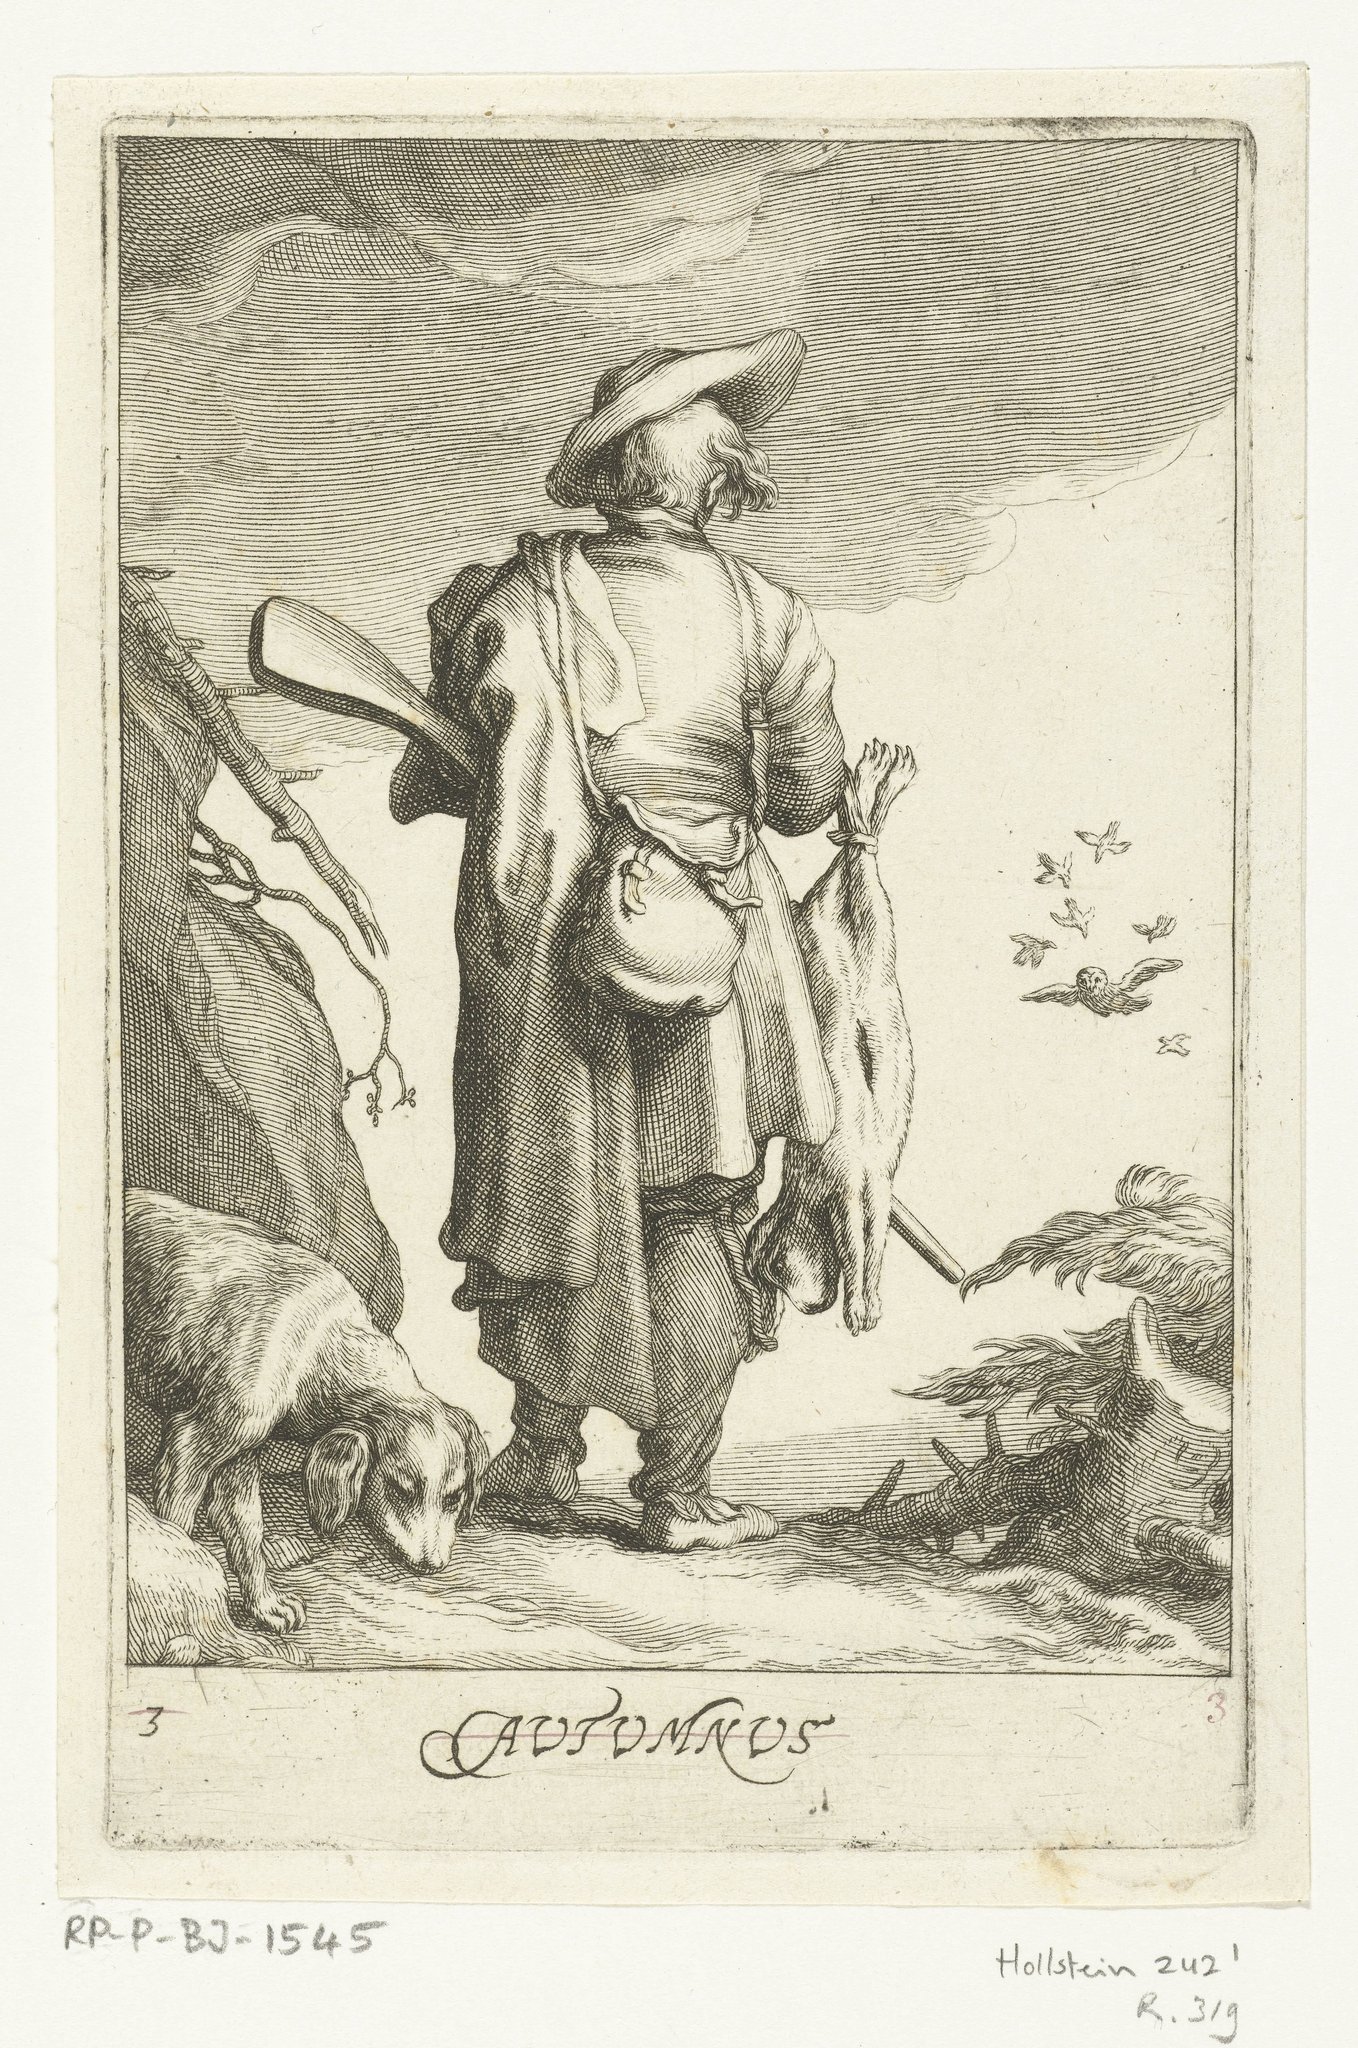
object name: print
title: De vier seizoenen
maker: frederick bloemaert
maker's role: print maker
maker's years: 1614-1669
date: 1632-1670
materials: paper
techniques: engraving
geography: utrecht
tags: autumn, fall, 'autumnus'; 'autunno' (ripa), return from the hunt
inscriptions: number: ‘3’, number: ‘3’, collector's mark: Lugt 240, inscription: ‘Autumnus’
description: Een jager, op de rug gezien, met een geweer, buideltas en een geschoten stuk wild, met zijn hond lopend over landweg. Vogels in de lucht.